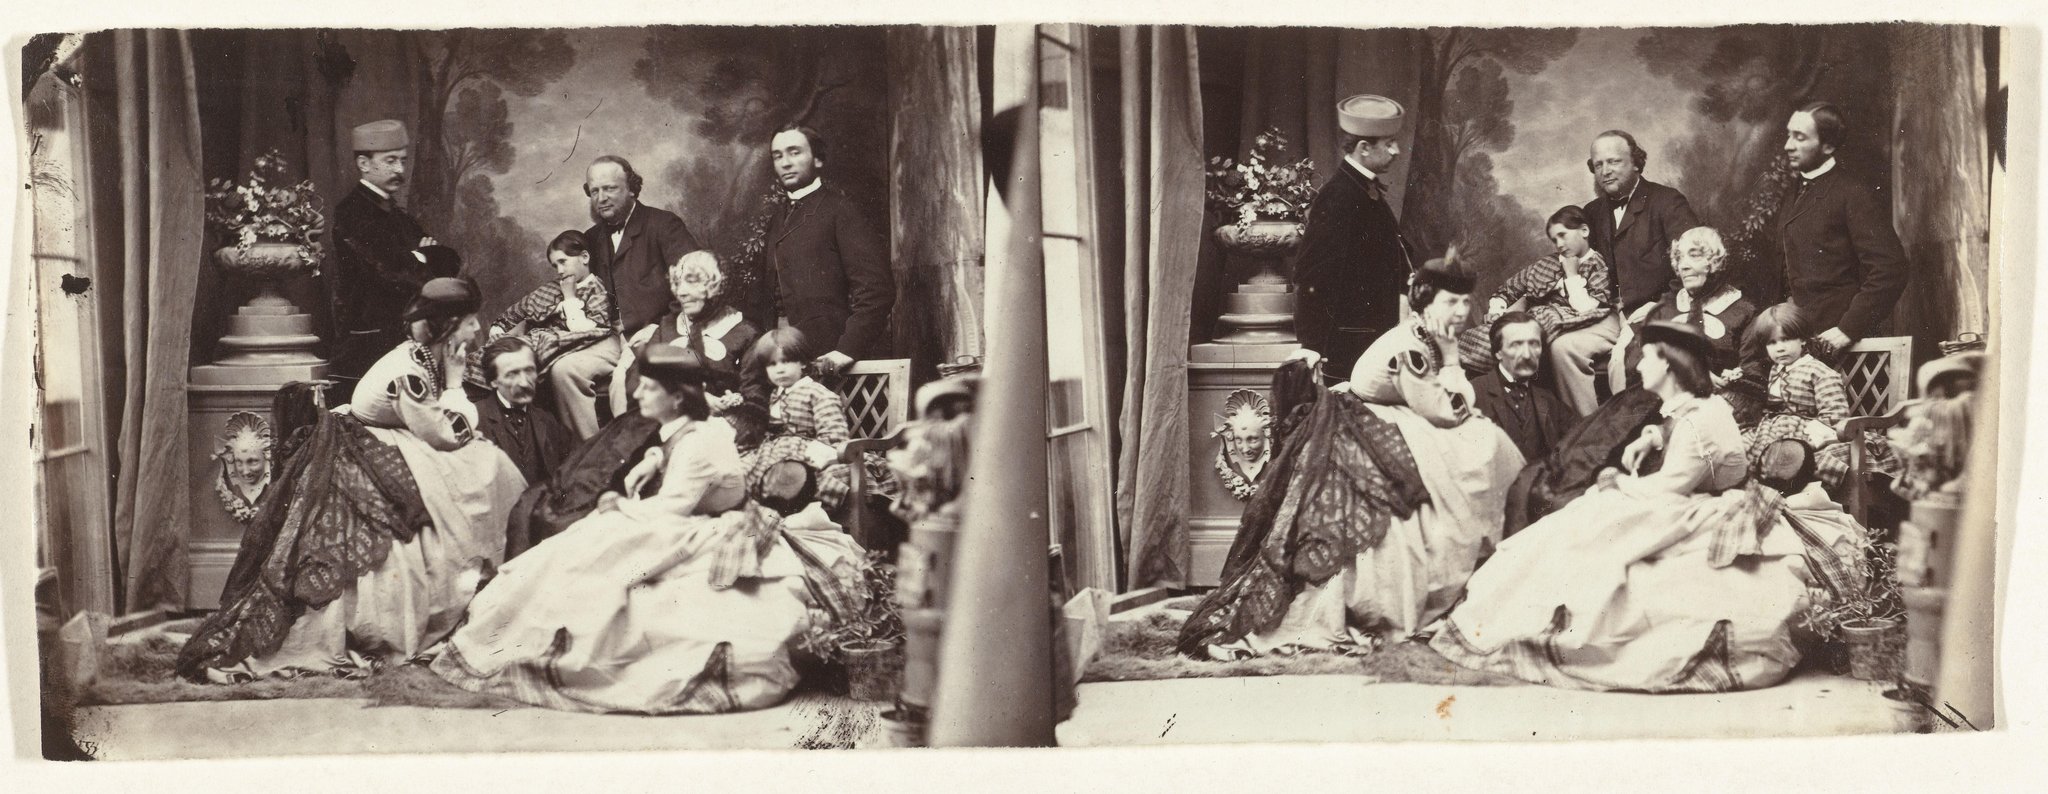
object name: photograph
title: Twee groepsportretten van een onbekende familie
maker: charles nègre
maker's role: fotograaf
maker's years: 1820-1880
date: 1855-1863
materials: paper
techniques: albumen print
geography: france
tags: family group, especially parents with their child(ren), anonymous historical persons portrayed in a group, in a group-portrait, france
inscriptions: inscription: ‘G 26 No. 119’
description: Onversneden vel met twee afdrukken van verschillende negatieven.